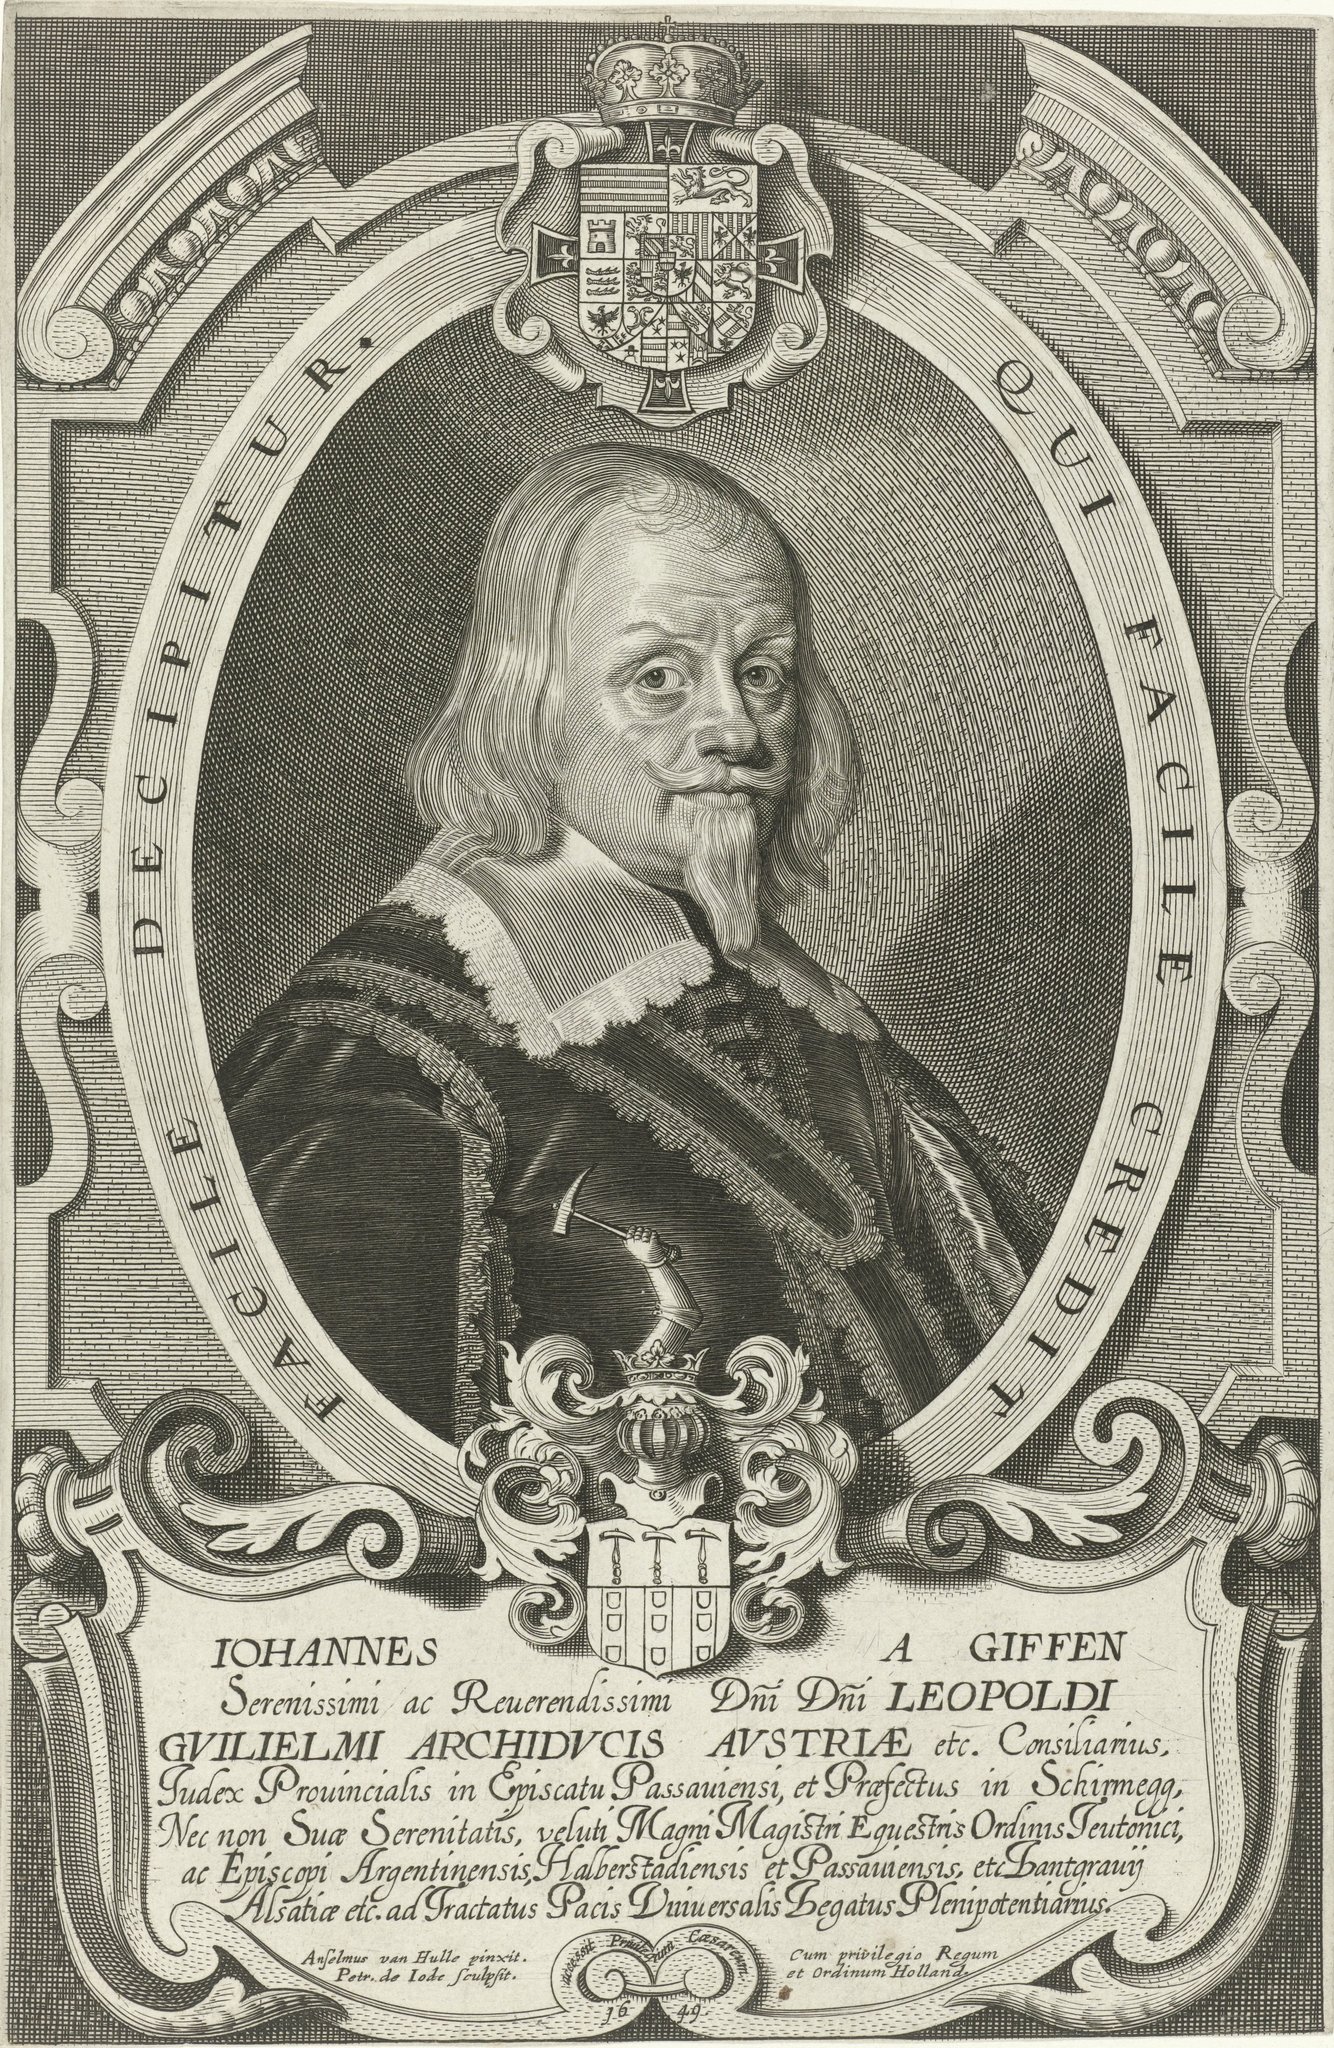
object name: print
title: Portret van Johann van Giffen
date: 1649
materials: paper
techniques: engraving, etching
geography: antwerp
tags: johann giffen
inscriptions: collector's mark: Lugt 2228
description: Portret van Johann van Giffen. Het portret is gevat in een ovale omlijsting met het wapenschild van de geportretteerde en een randschrift in het Latijn. In de cartouche een zevenregelig onderschrift in het Latijn. Prent uit een serie portretten naar schilderijen van Anselmus van Hulle van alle gedelegeerden bij de vredesonderhandelingen te Münster en Osnabrück.